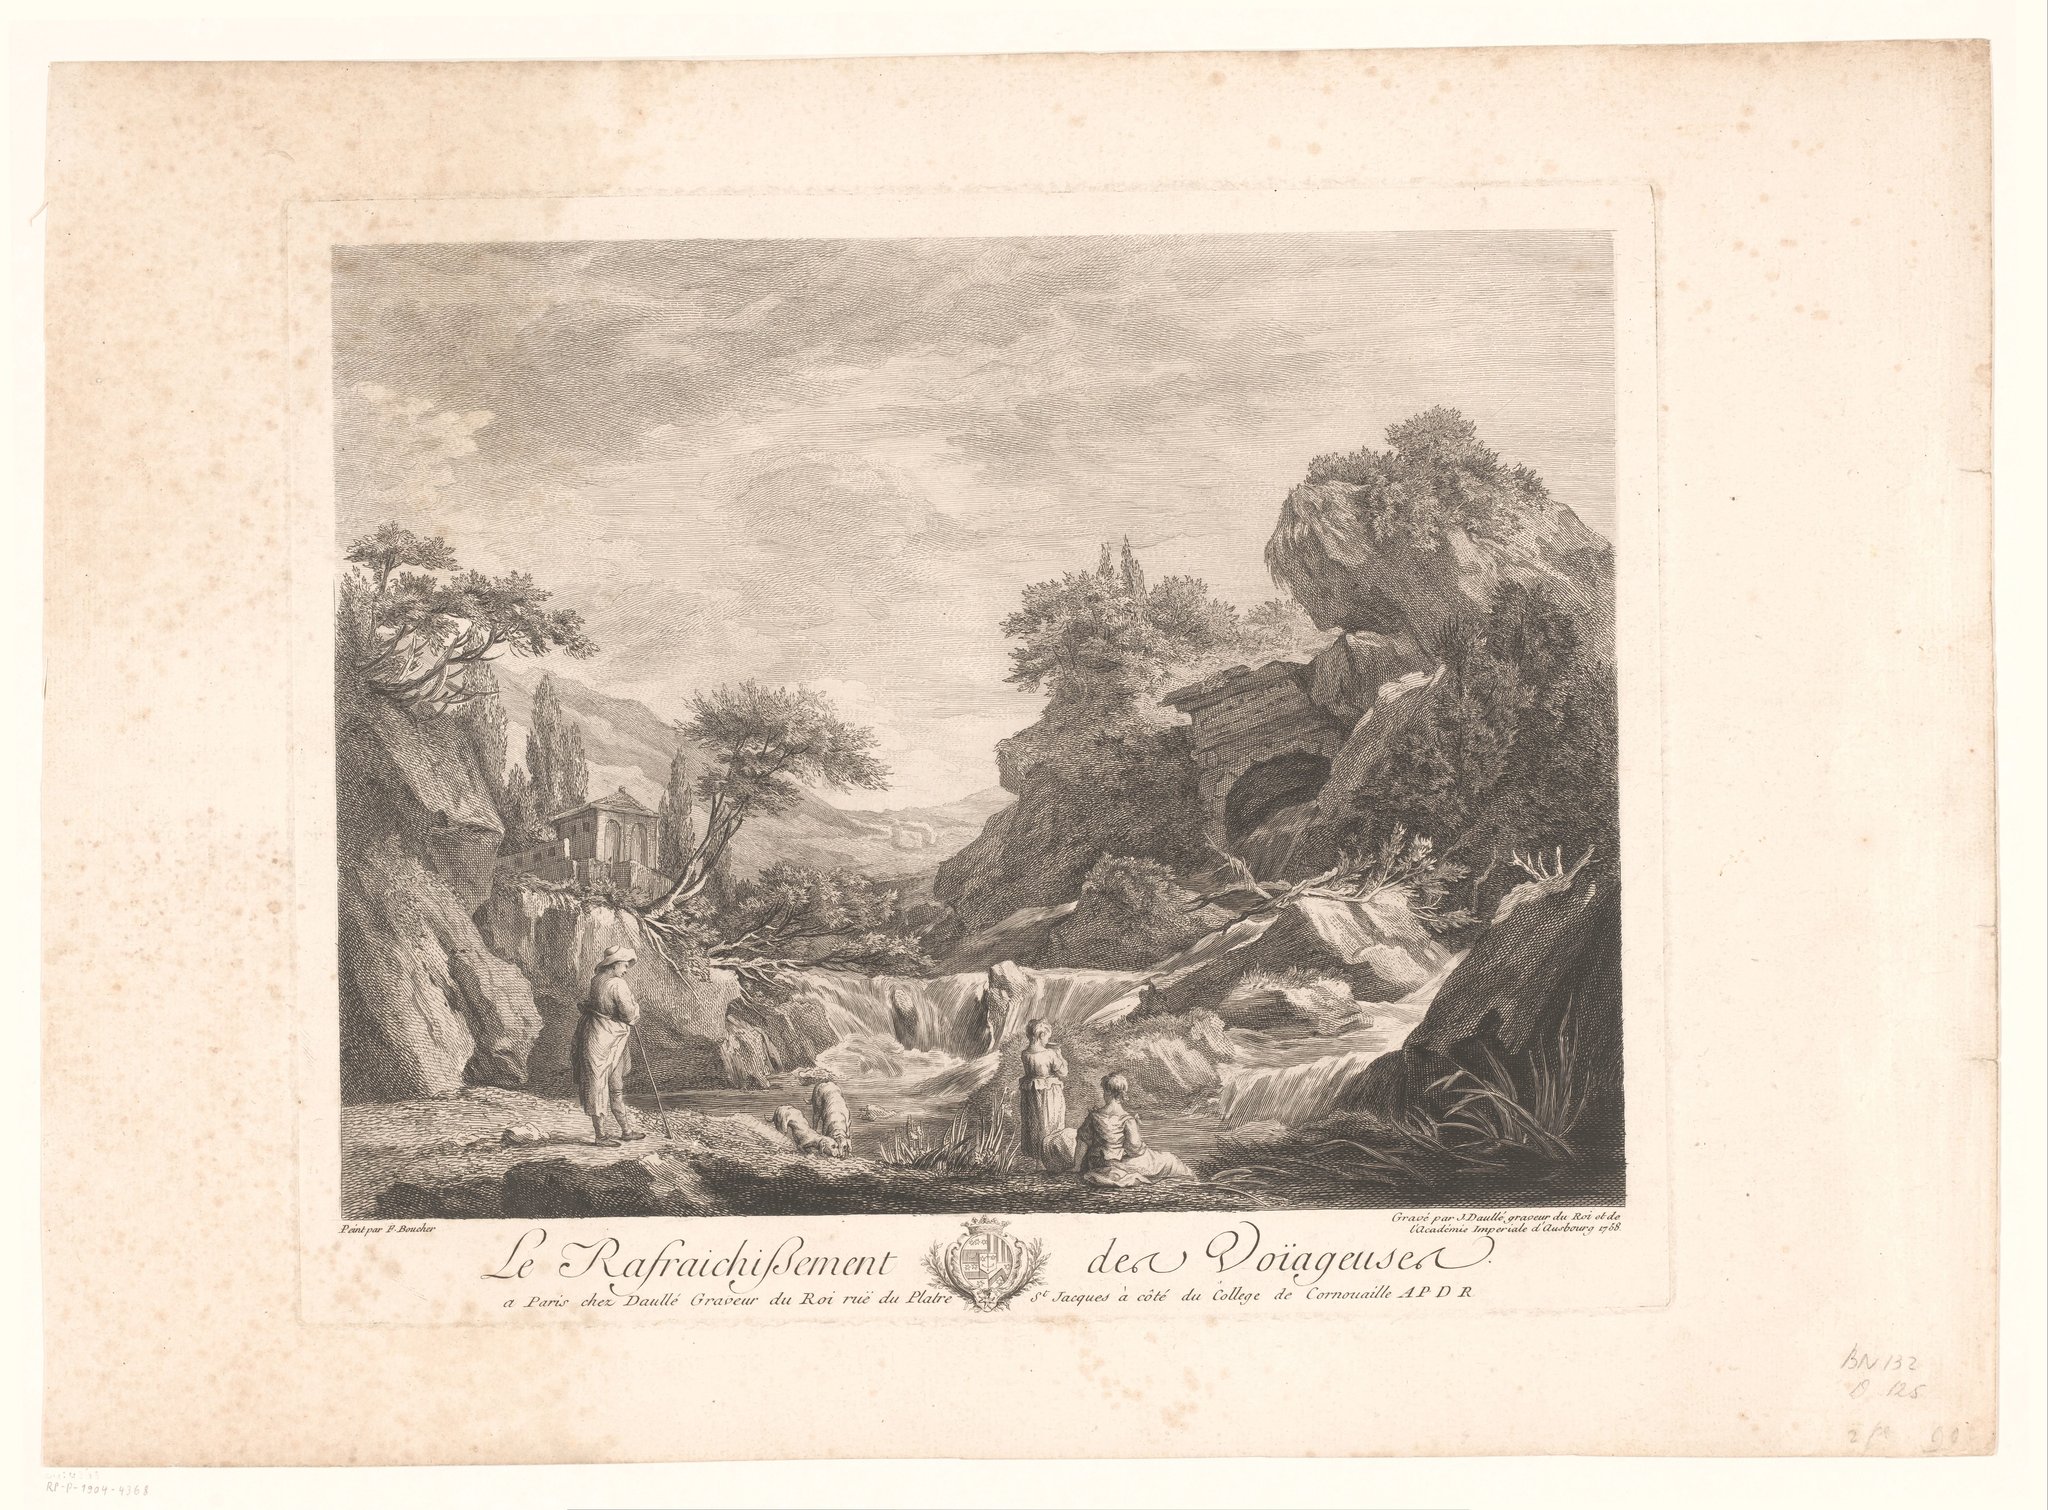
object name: print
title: Landschap met rustende reizigers bij een waterval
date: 1758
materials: paper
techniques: engraving, etching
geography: paris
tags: landscapes, waterfall, (traveller) resting in the open air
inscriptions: collector's mark: Lugt 2228